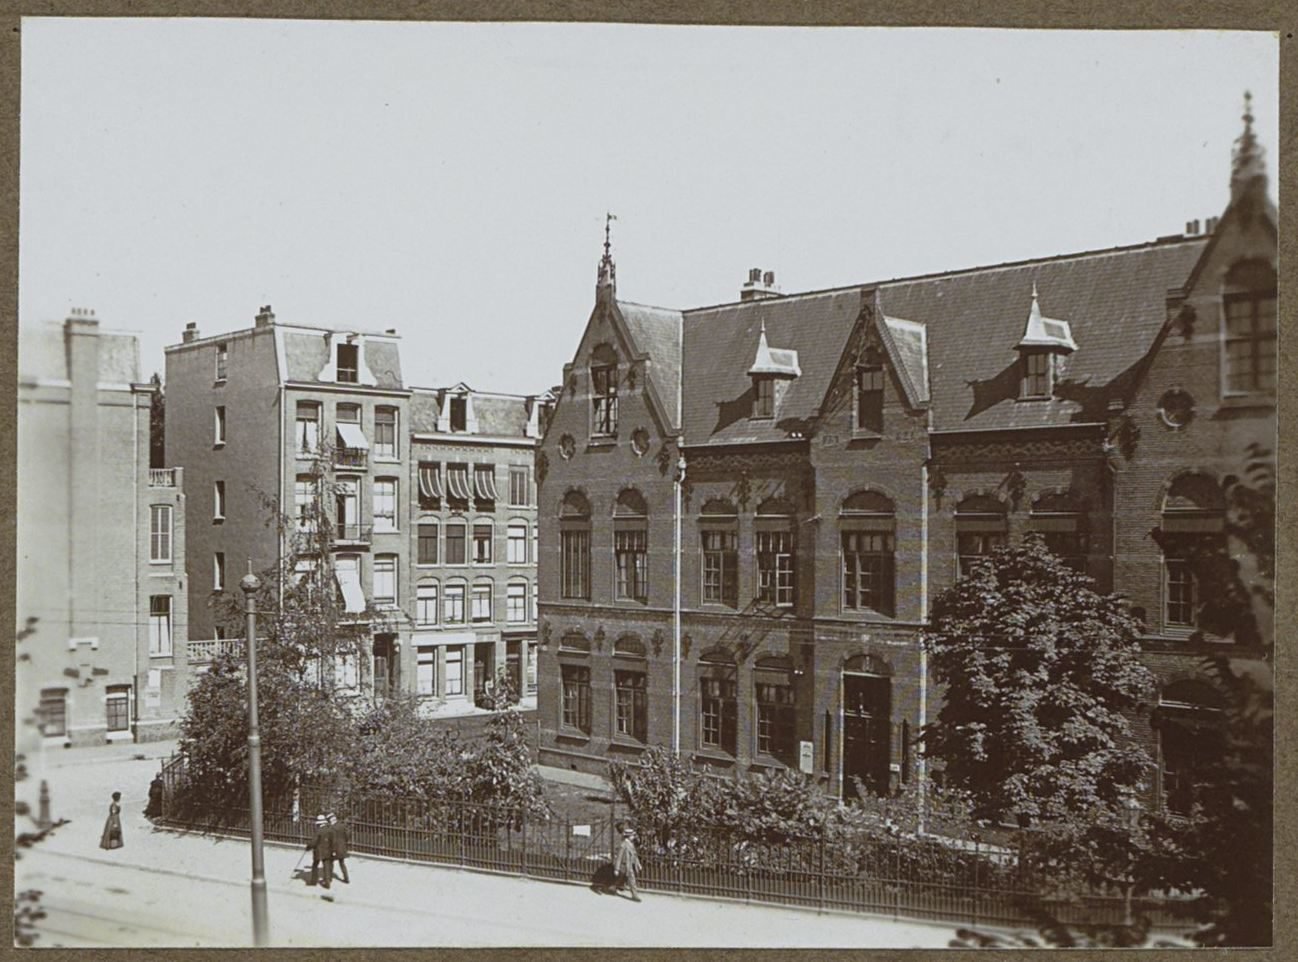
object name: photograph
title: Gebouw van de Tweede HBS aan de Roelof Hartstraat te Amsterdam, met links de ingang van de Balthasar Floriszstraat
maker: Anonymous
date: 1910-1930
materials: paper, photographic support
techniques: gelatin silver print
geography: amsterdam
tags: secondary education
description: Onderdeel van Album met foto's van Amsterdam en omgeving.